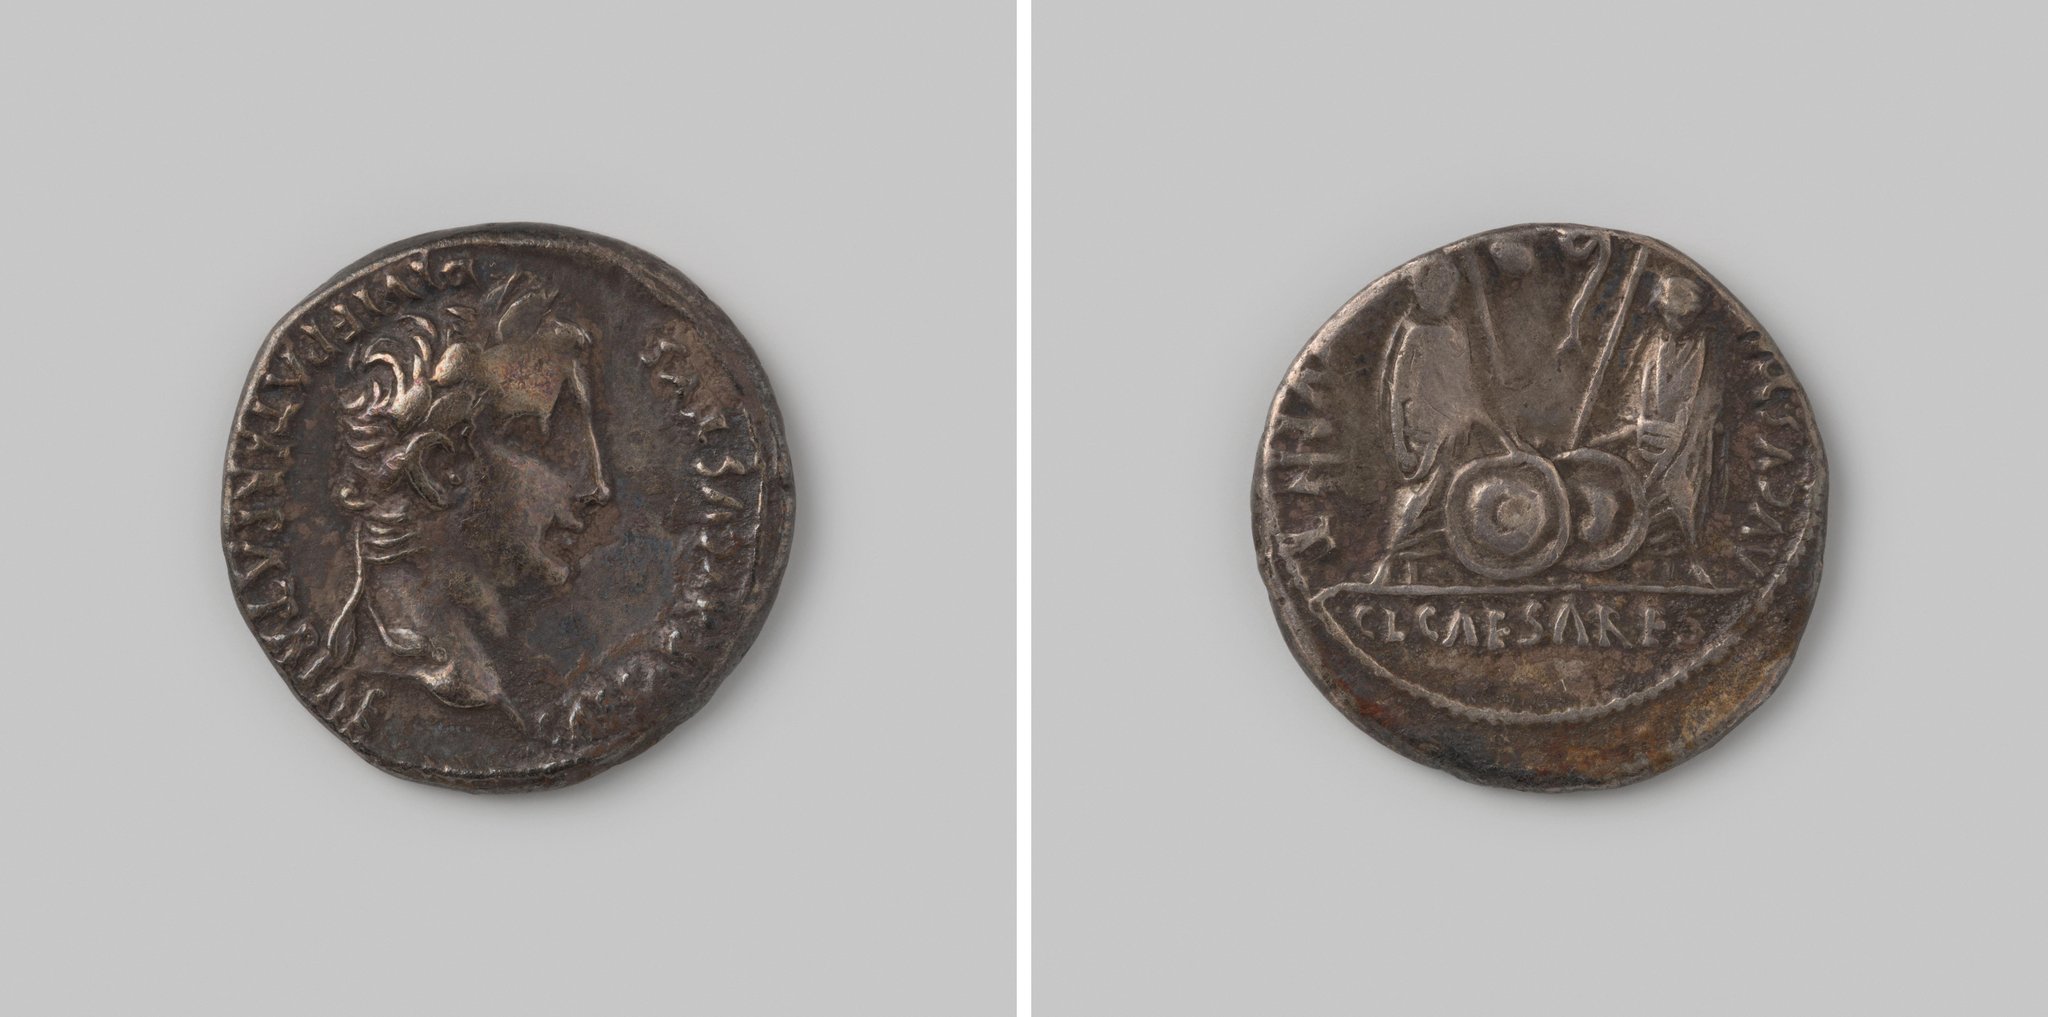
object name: denarius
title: Denarius uit het Romeinse Keizerrijk van Augustus, 27 v. Chr. - 14 n. Chr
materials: silver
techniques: striking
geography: lugdunum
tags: gaius vipsanius agrippa, caesar, lucius julius caesar vipsanianus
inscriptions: circumscription: ‘AVGVSTI [F COS DESIG PRINC IV]VENT’, circumscription (false): ‘CAESAR AVGVSTVS DIVI F PATER PATRIAE’, inscription: ‘C L CAESARES’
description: keerzijde: twee naar elkaar toegewende staande mannen, Gaius en Lucius, met toga, schild en speer, tussen hen in een simpulum (links) en lituus (rechts), omschrift in afsnede